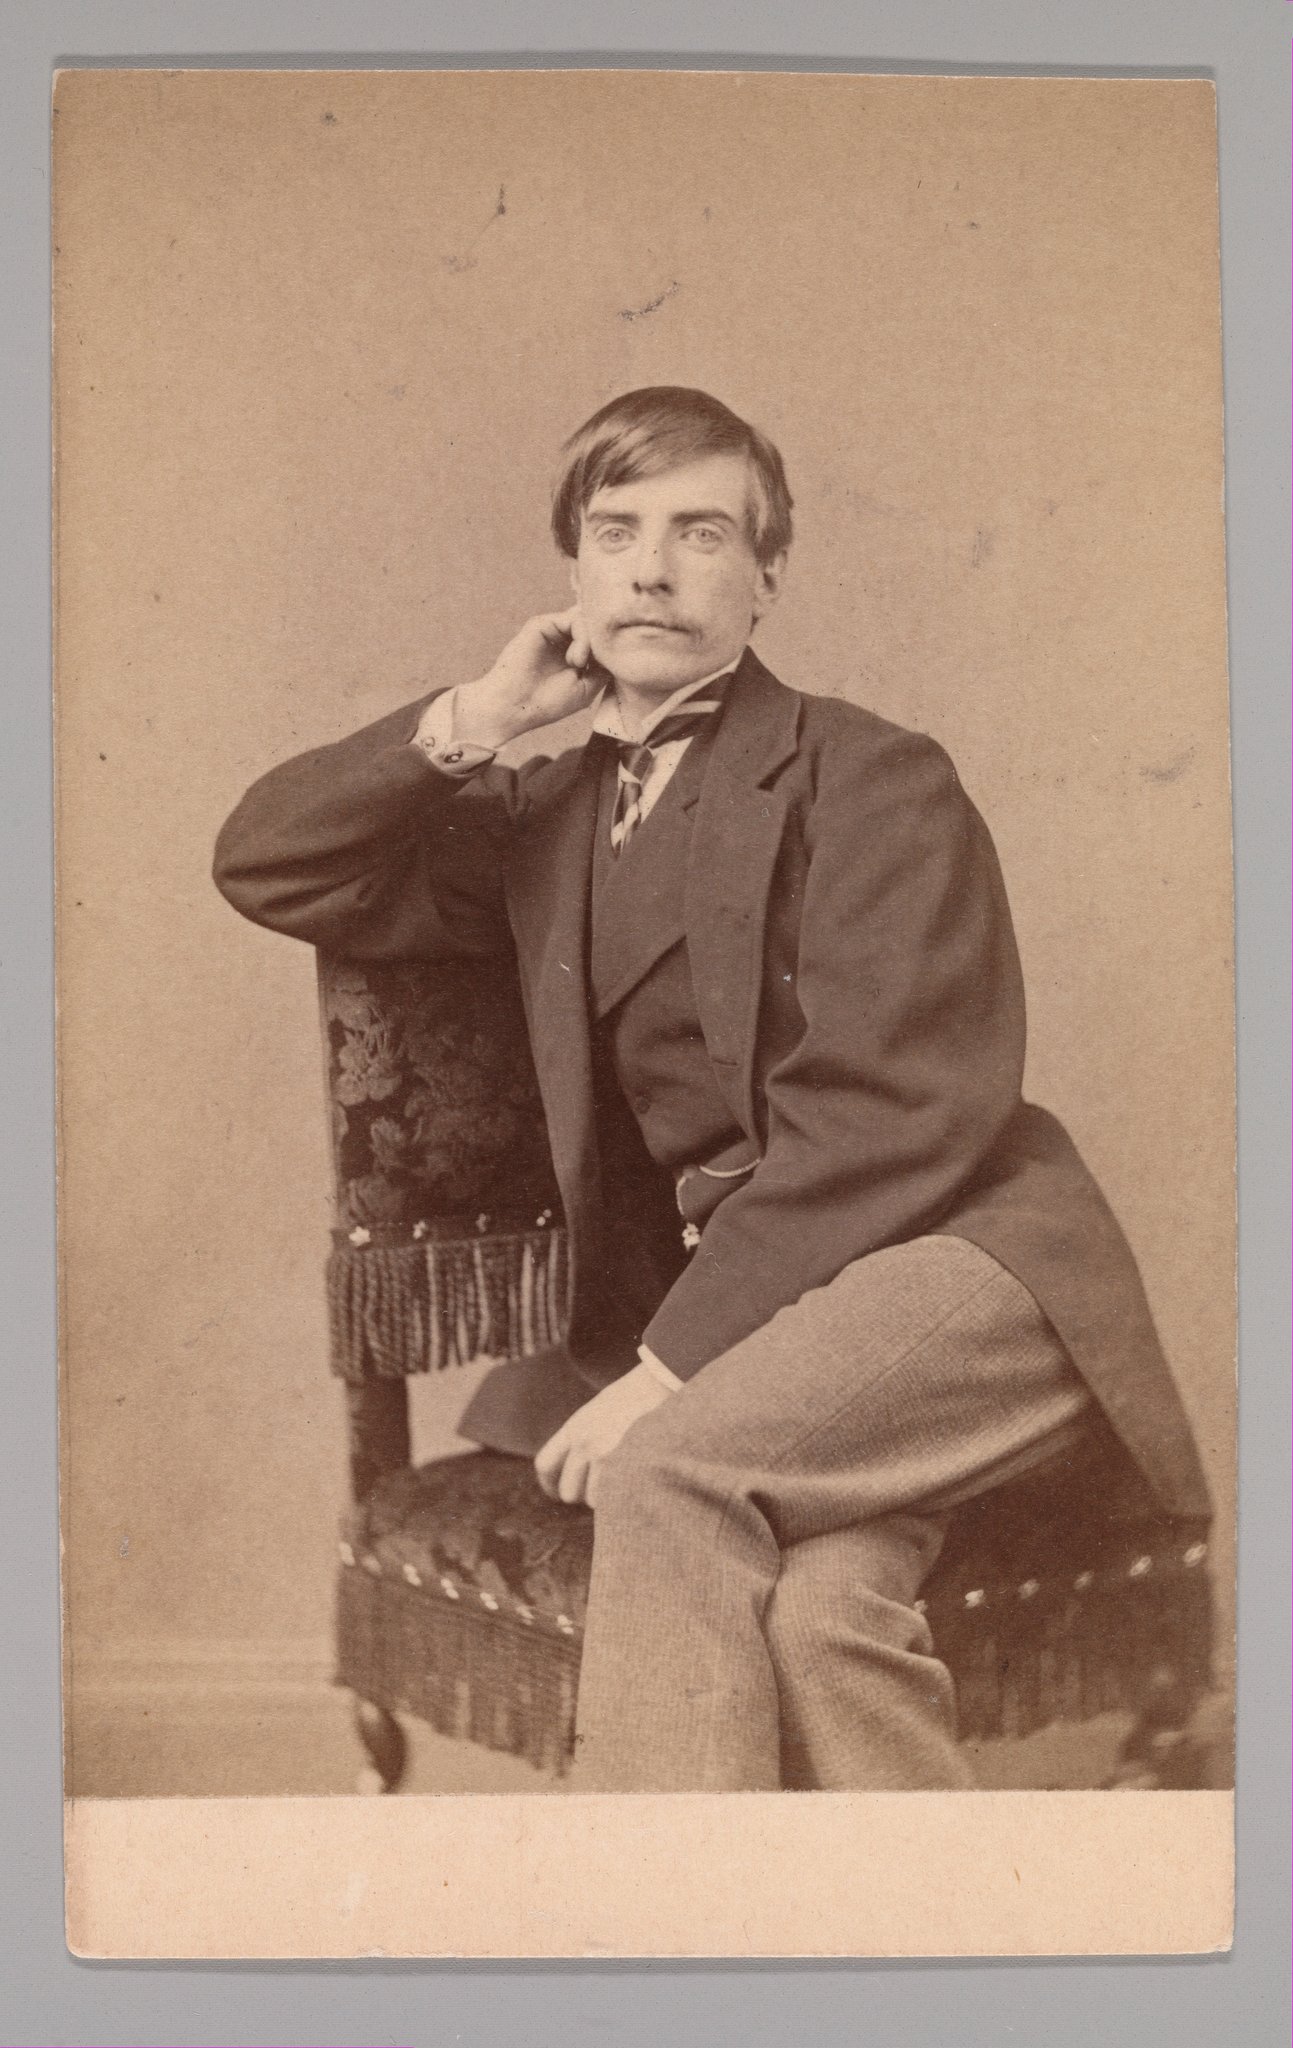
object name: carte de visite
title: [? Walker]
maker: Anonymous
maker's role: artist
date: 1860-1869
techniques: albumen silver print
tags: men,portraits